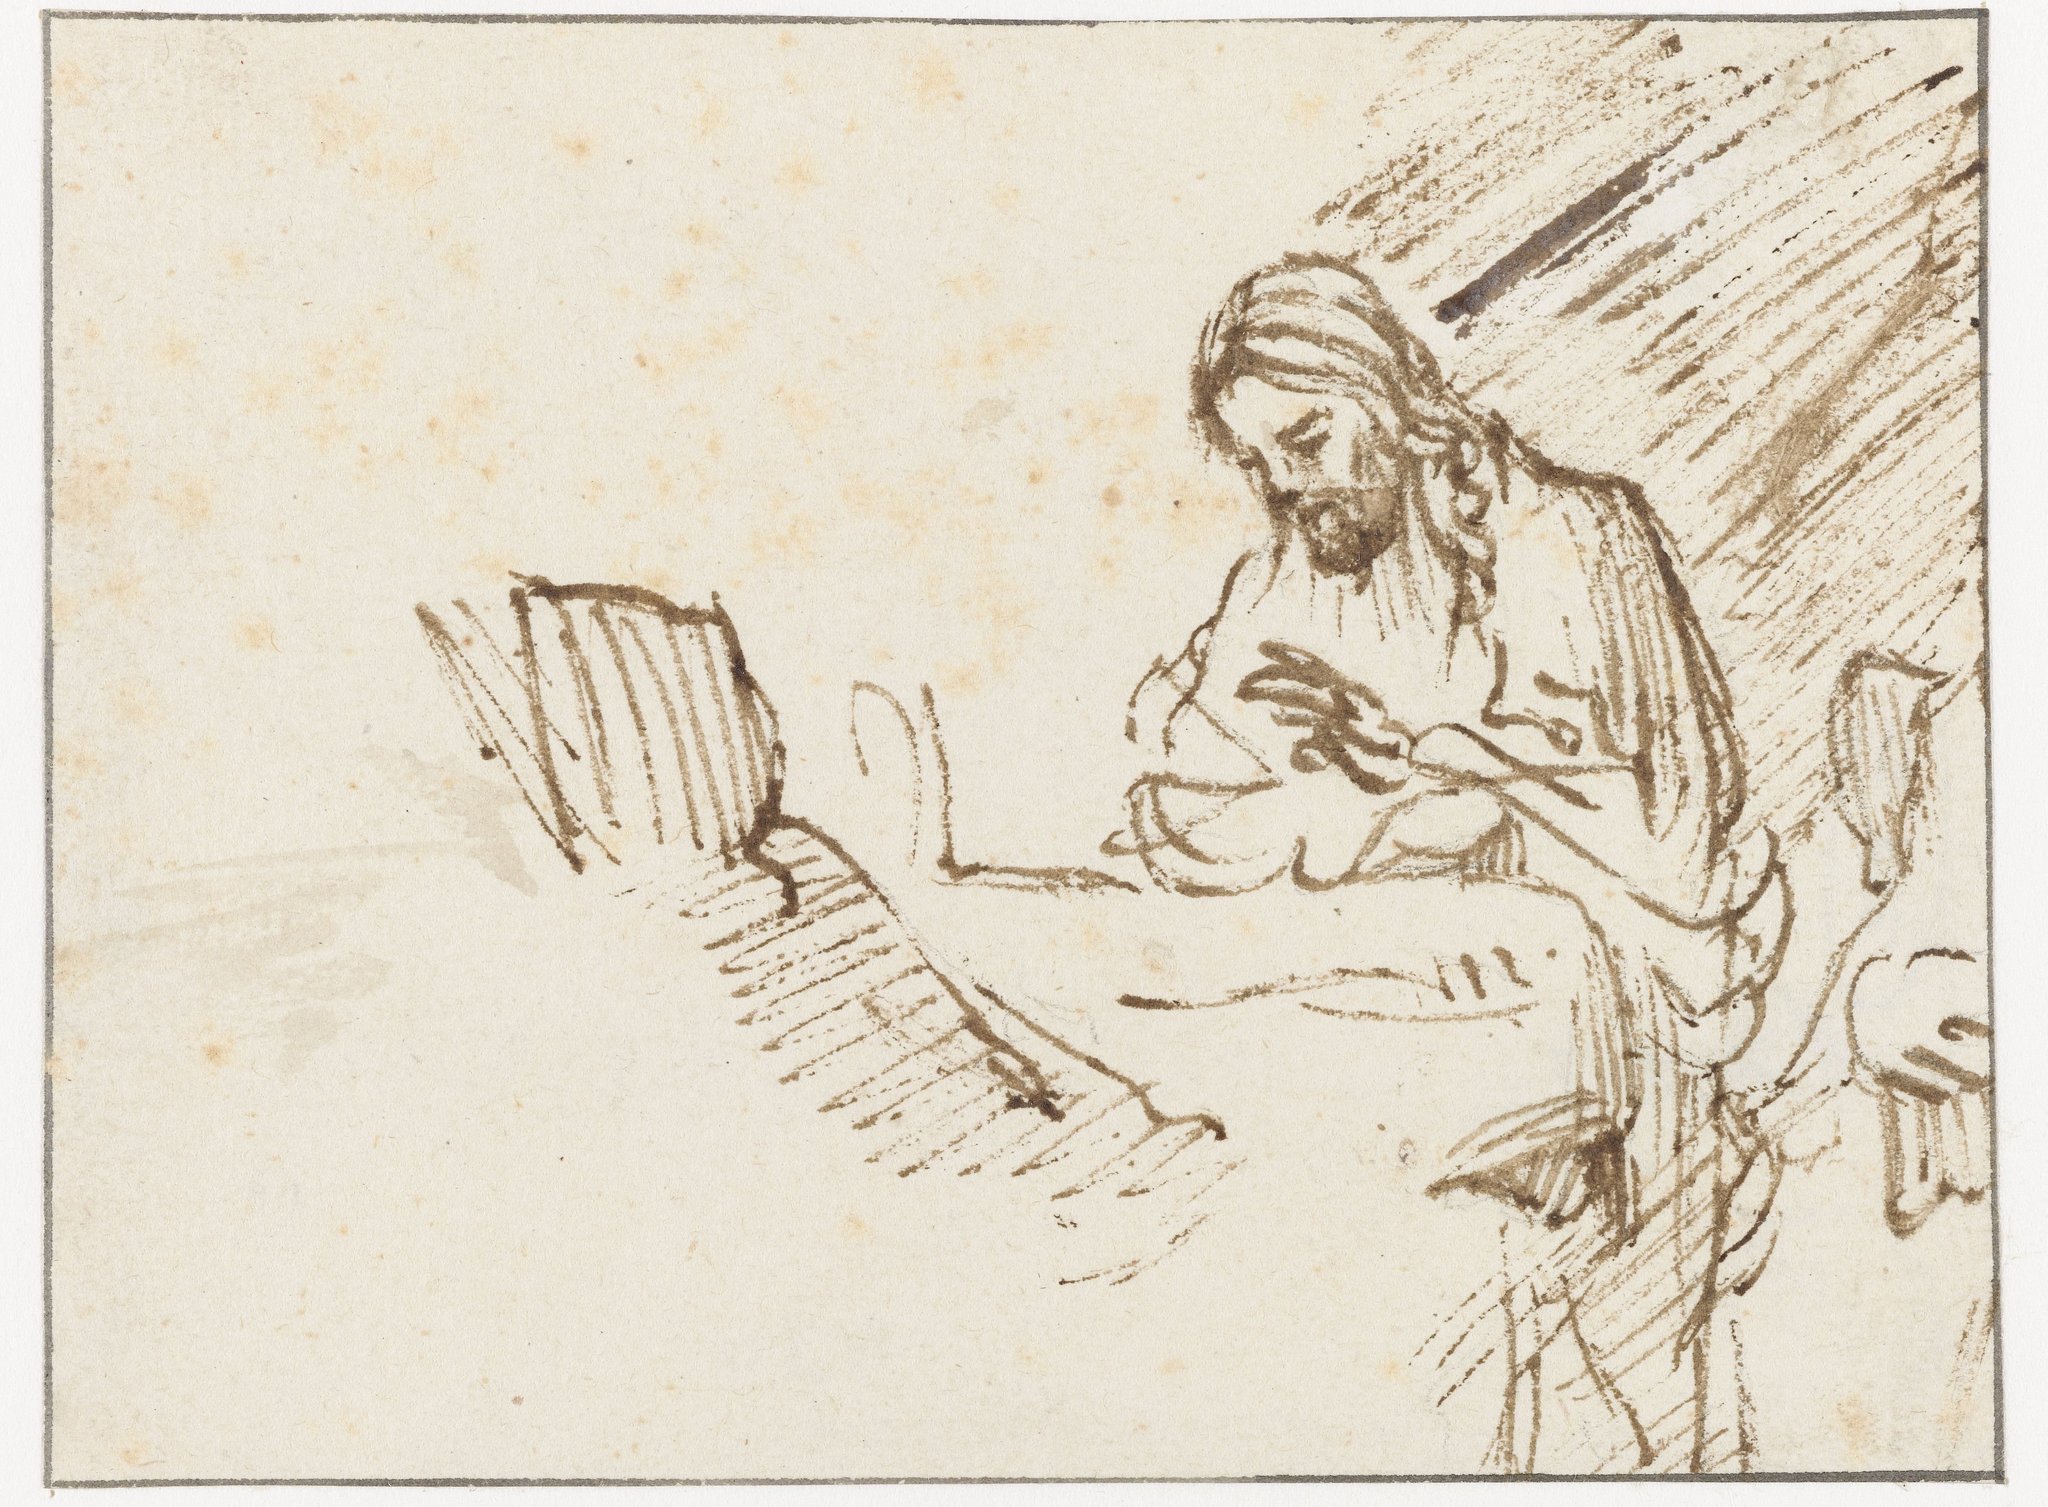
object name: drawing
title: Temptation of Christ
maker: Anonymous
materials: ink, paper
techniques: brush, pen